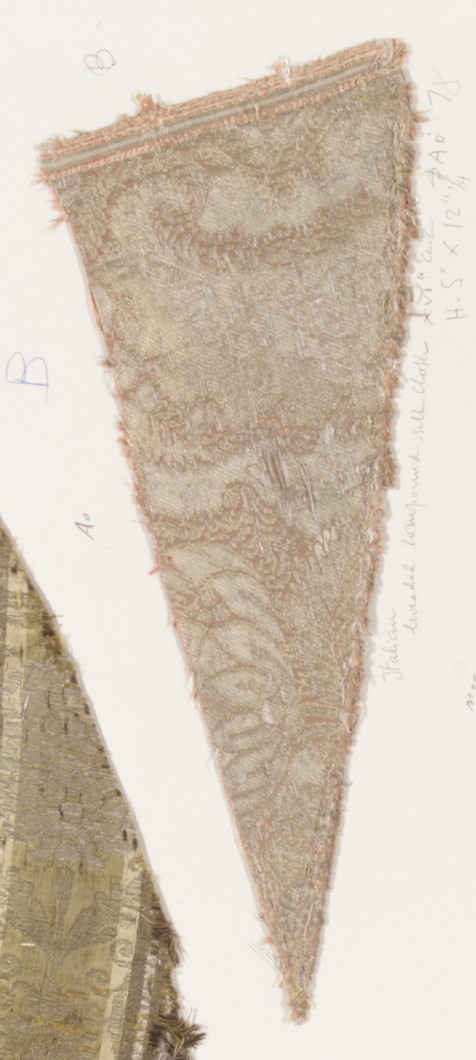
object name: fragment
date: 1501-1600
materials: silk